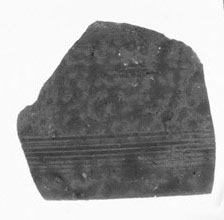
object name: fragment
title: Fragment of a Bowl (Study Collection)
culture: chinese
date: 1046-256 BCE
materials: ceramic glaze, ceramic, glaze